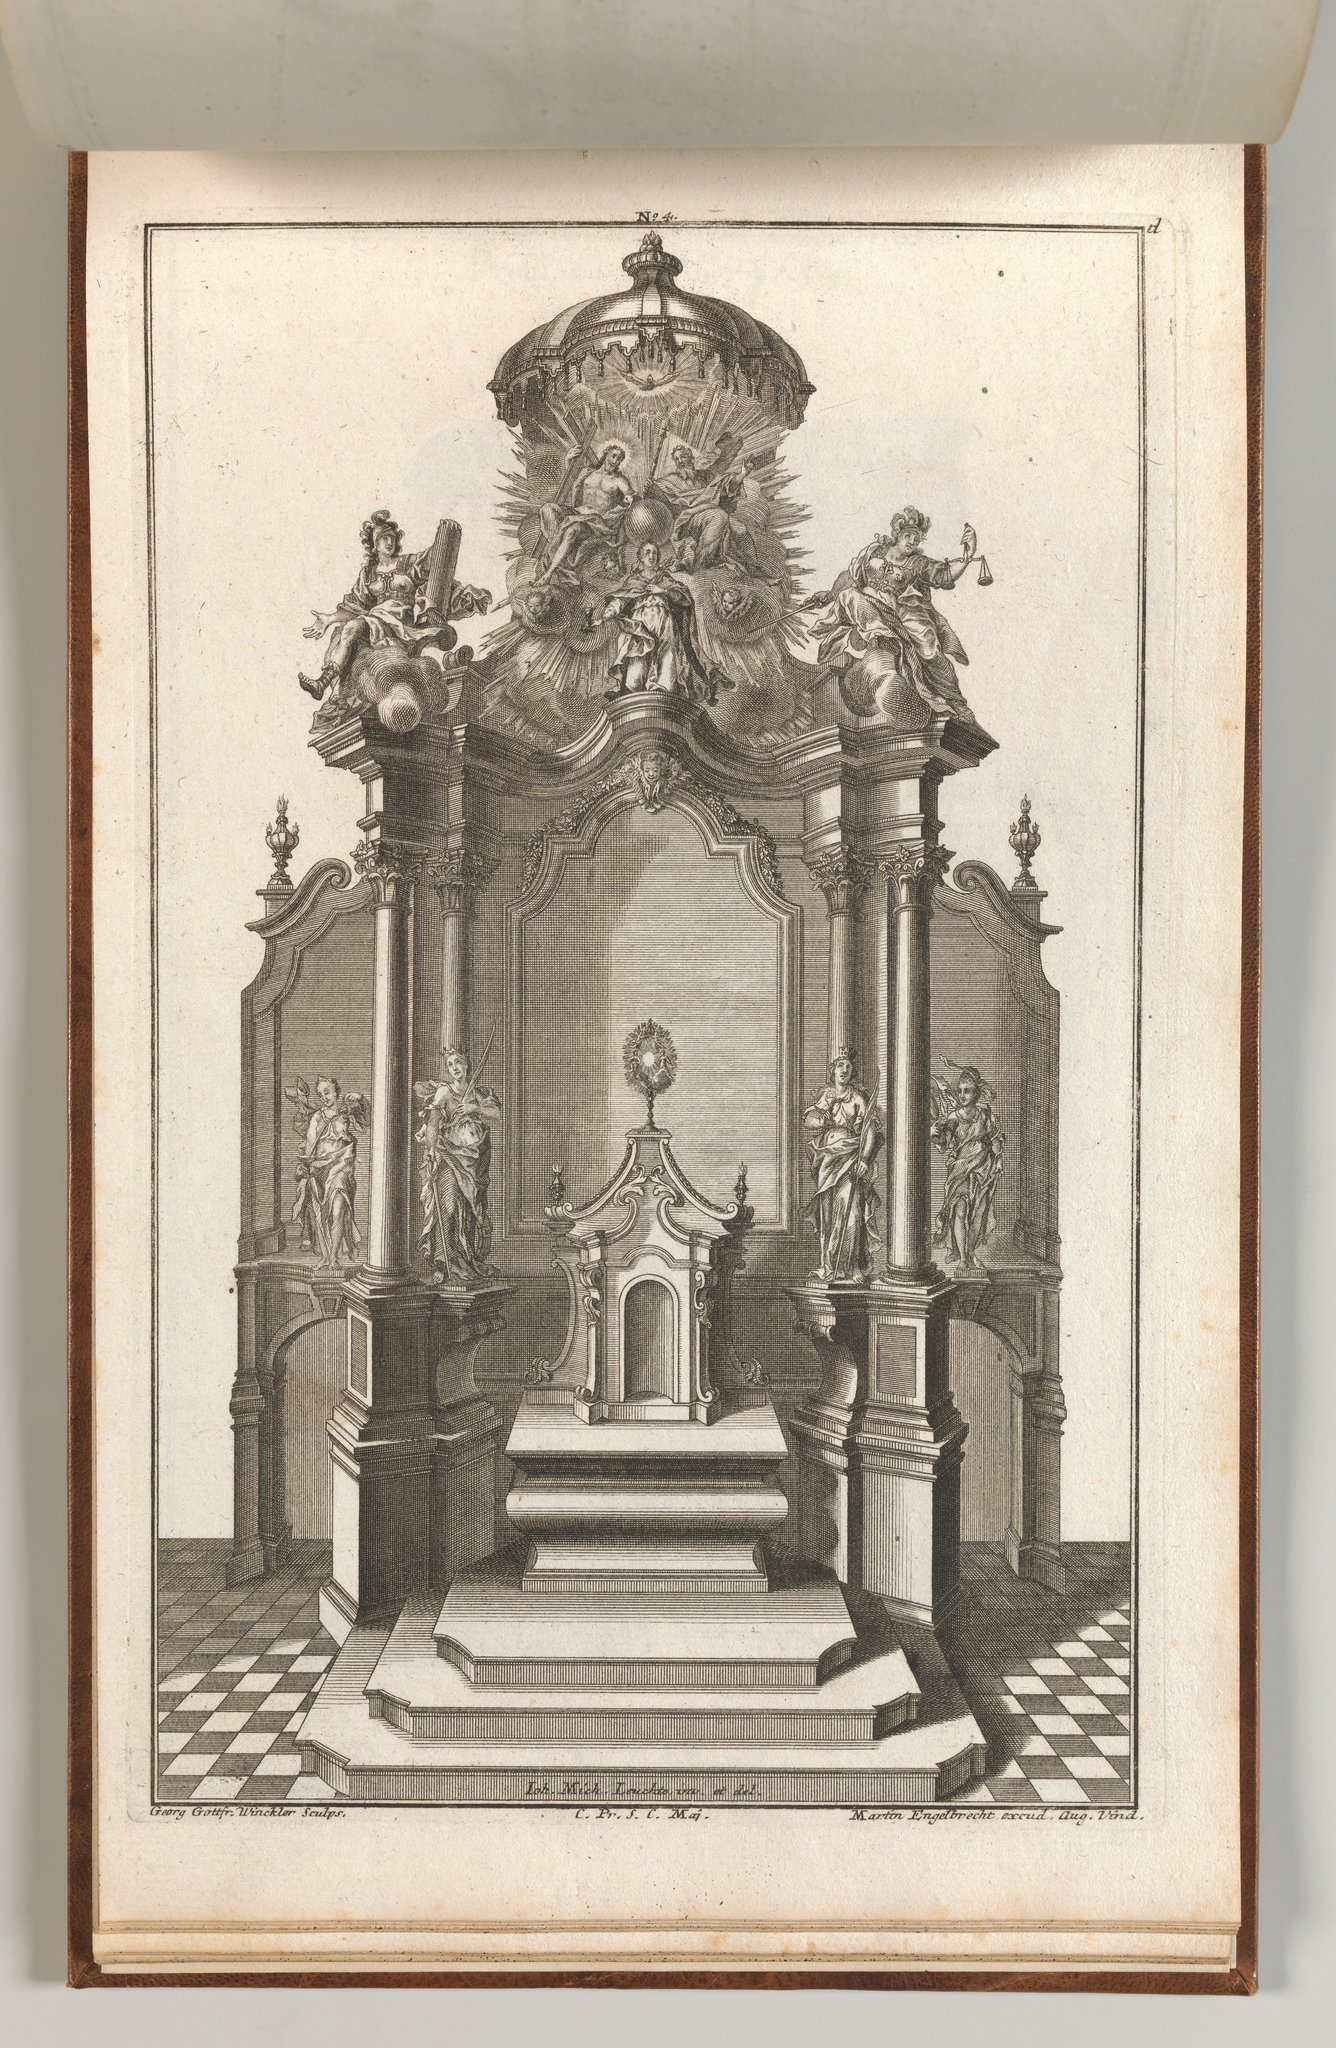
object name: album print ornament architecture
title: Design for a Monumental Altar, Plate d from 'Unterschiedliche Neu Inventierte Altäre mit darzu gehörigen Profillen u. Grundrißen.'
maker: georg gottfried winckler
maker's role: engraver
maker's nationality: german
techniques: etching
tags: altars,women,reliquaries